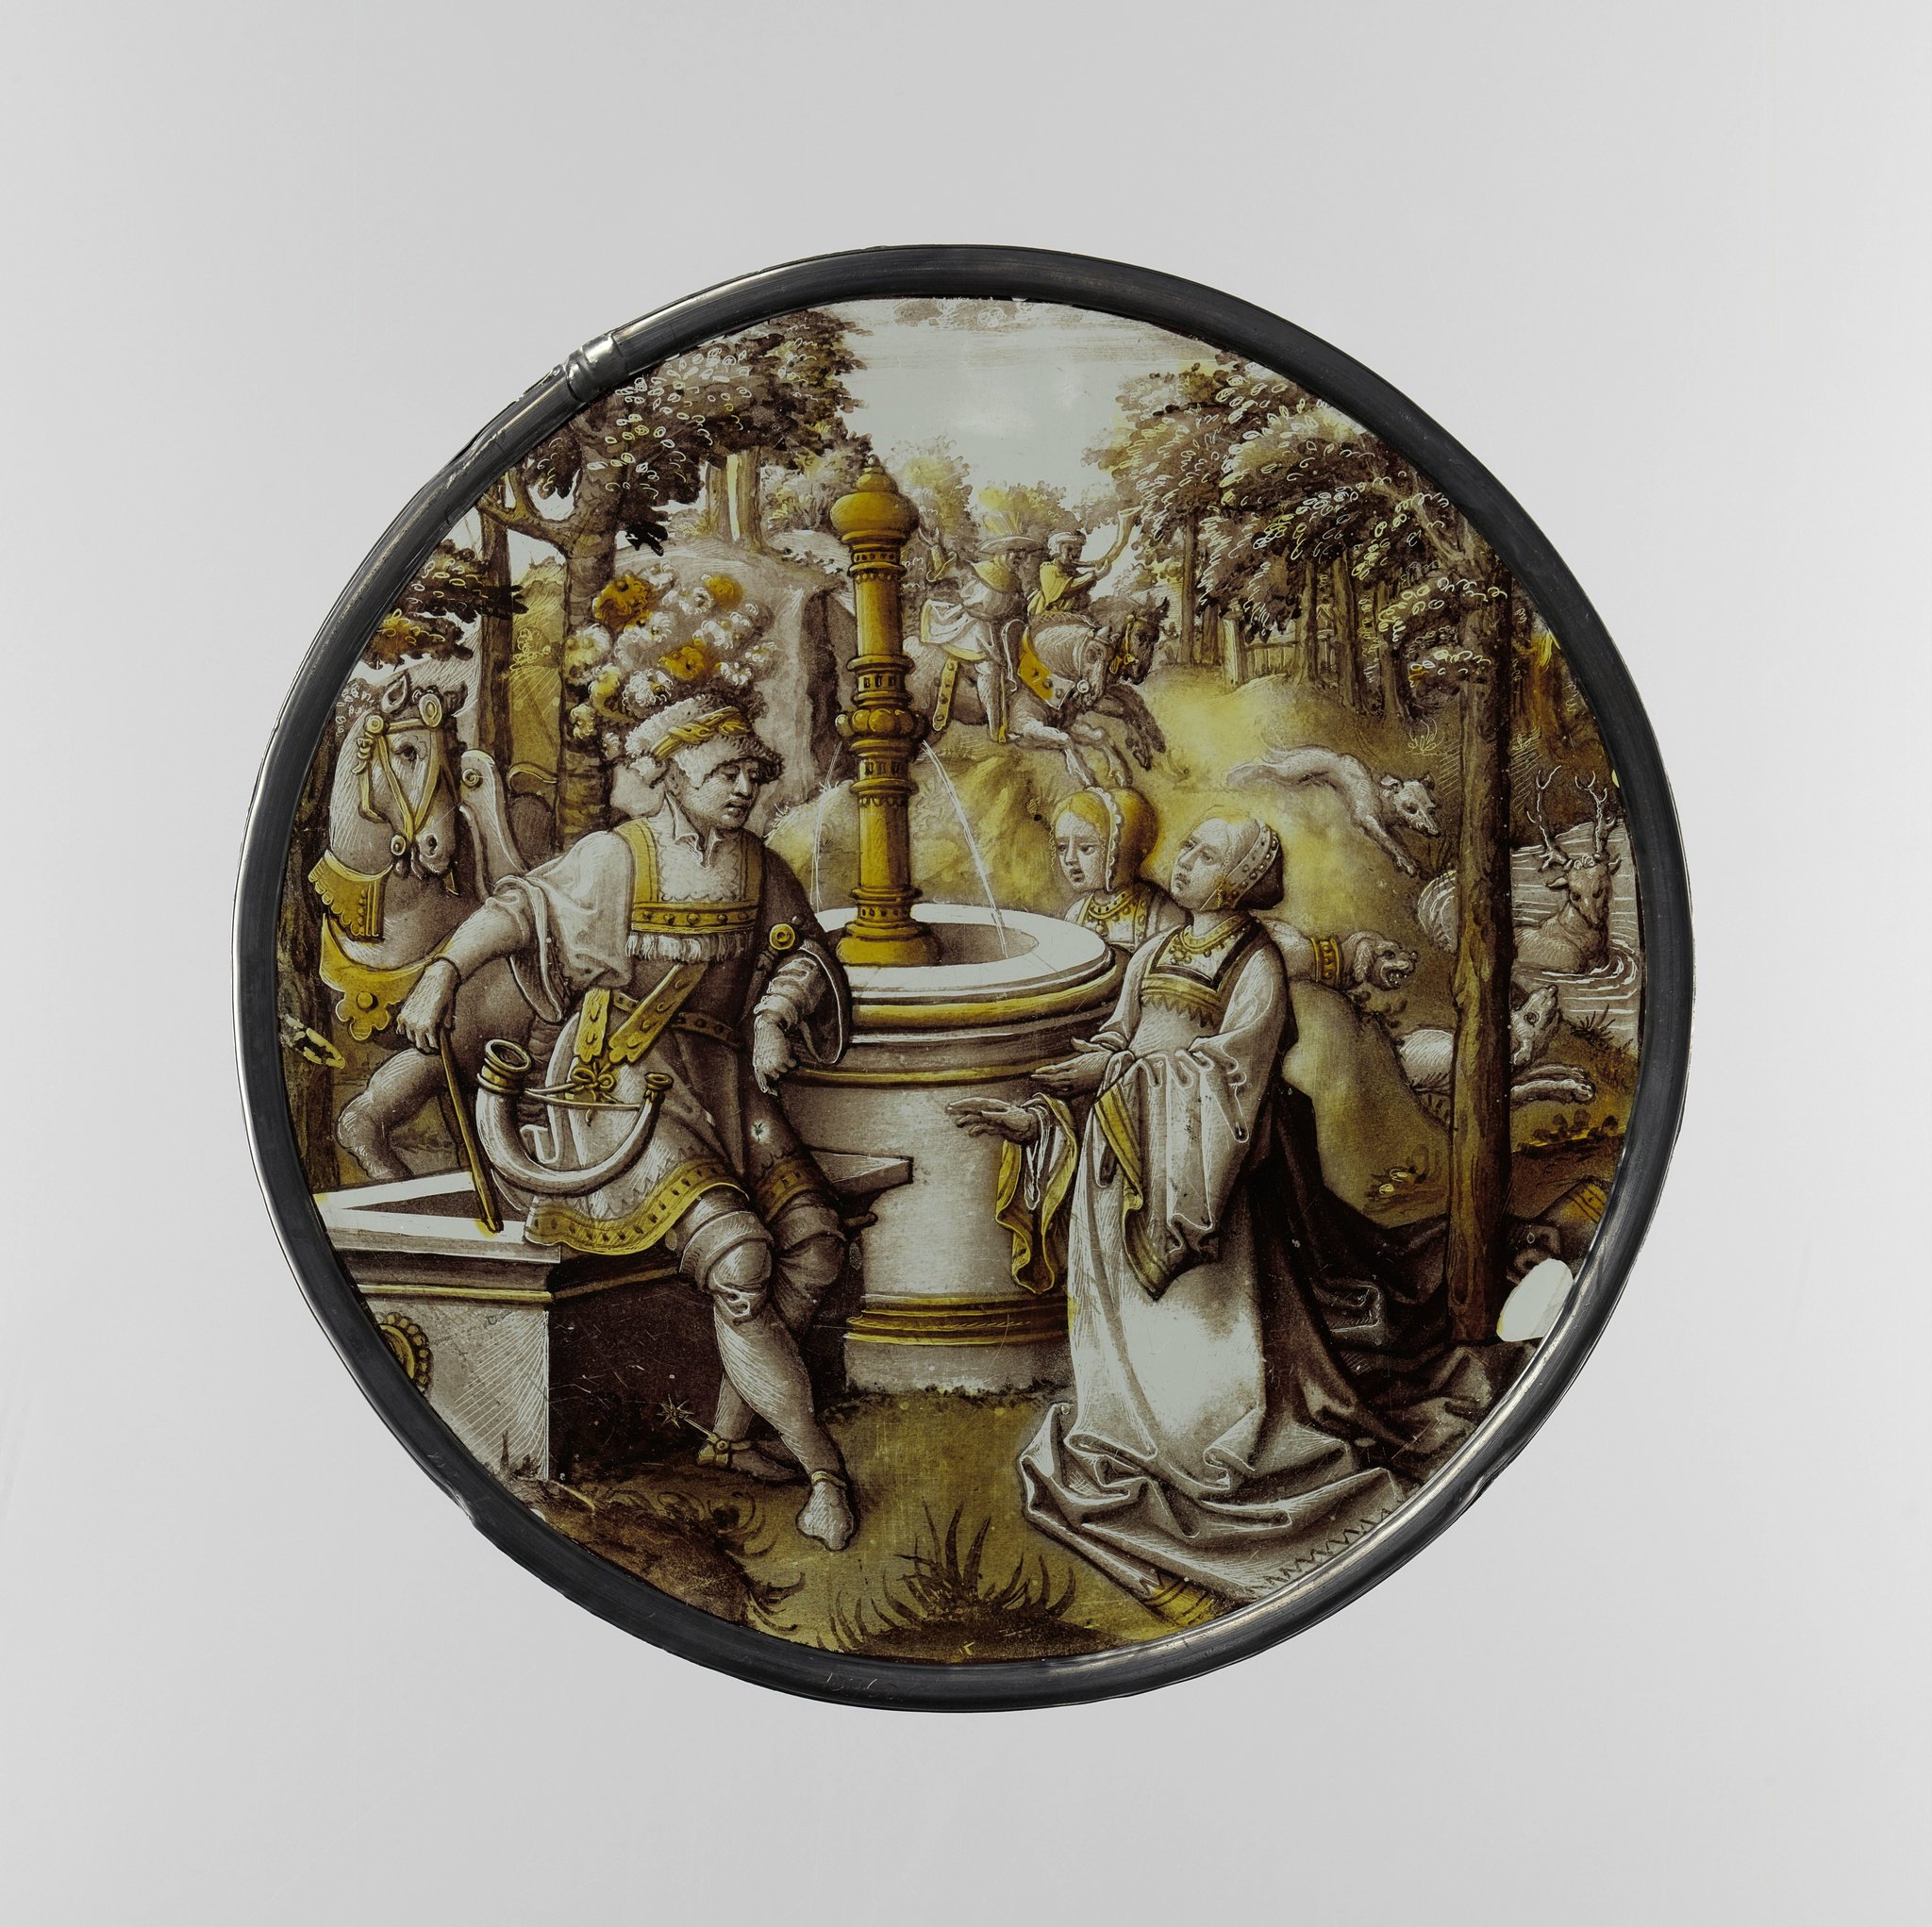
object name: light window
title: Ruit met een ridder bij een fontein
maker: aert ortkens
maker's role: draughtsman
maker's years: 1473-1540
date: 1525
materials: glass, lead, pigment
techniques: leading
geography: flanders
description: Knight by a fountain. Stained glass. Southern Netherlands, c. 1525, attributed to Aerdt Ortkens (active c. 1500 - 1520).